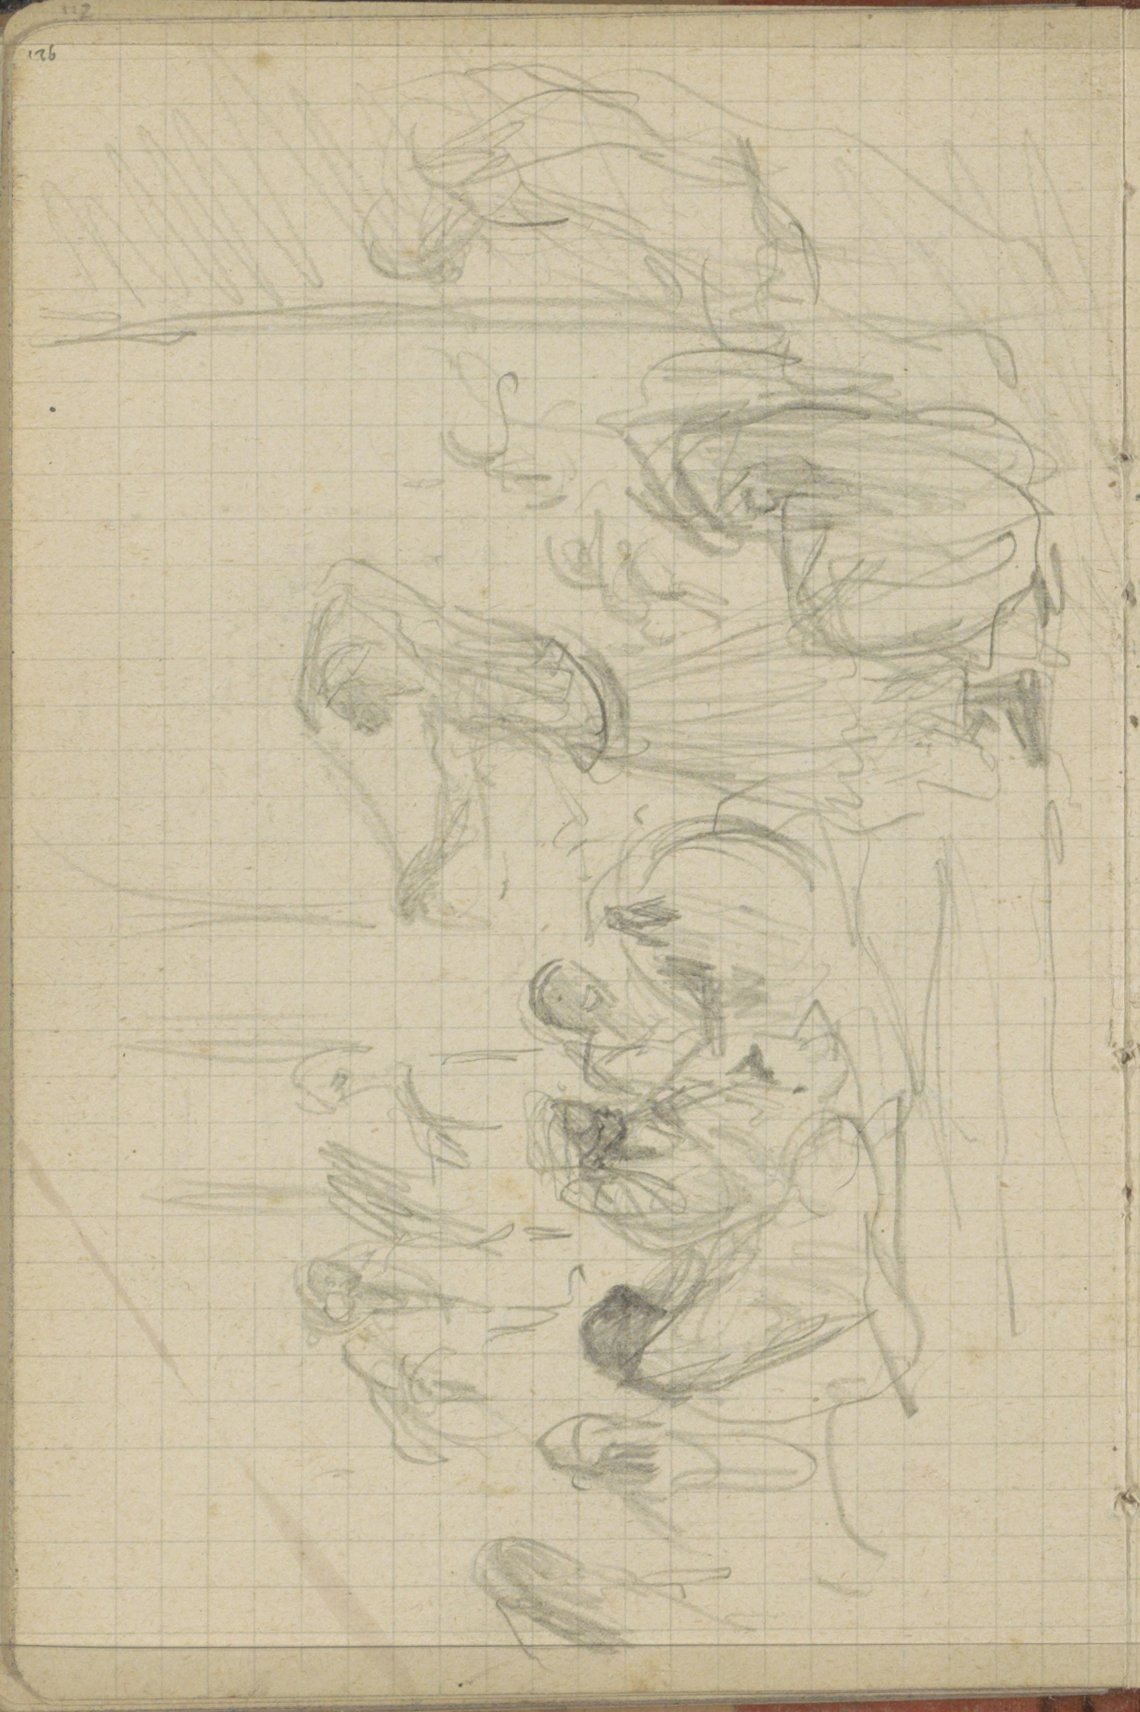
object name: sketchbook leaf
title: Straat met een slangenbezweerder, muzikanten en publiek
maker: marius bauer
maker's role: draughtsman, print maker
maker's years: 1867-1932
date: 1909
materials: pencil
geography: tunisia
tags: performance, snakes, making music; musician with instrument, street (+ city(-scape) with figures, staffage)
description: Pagina 126 uit een schetsboek met 67 bladen.